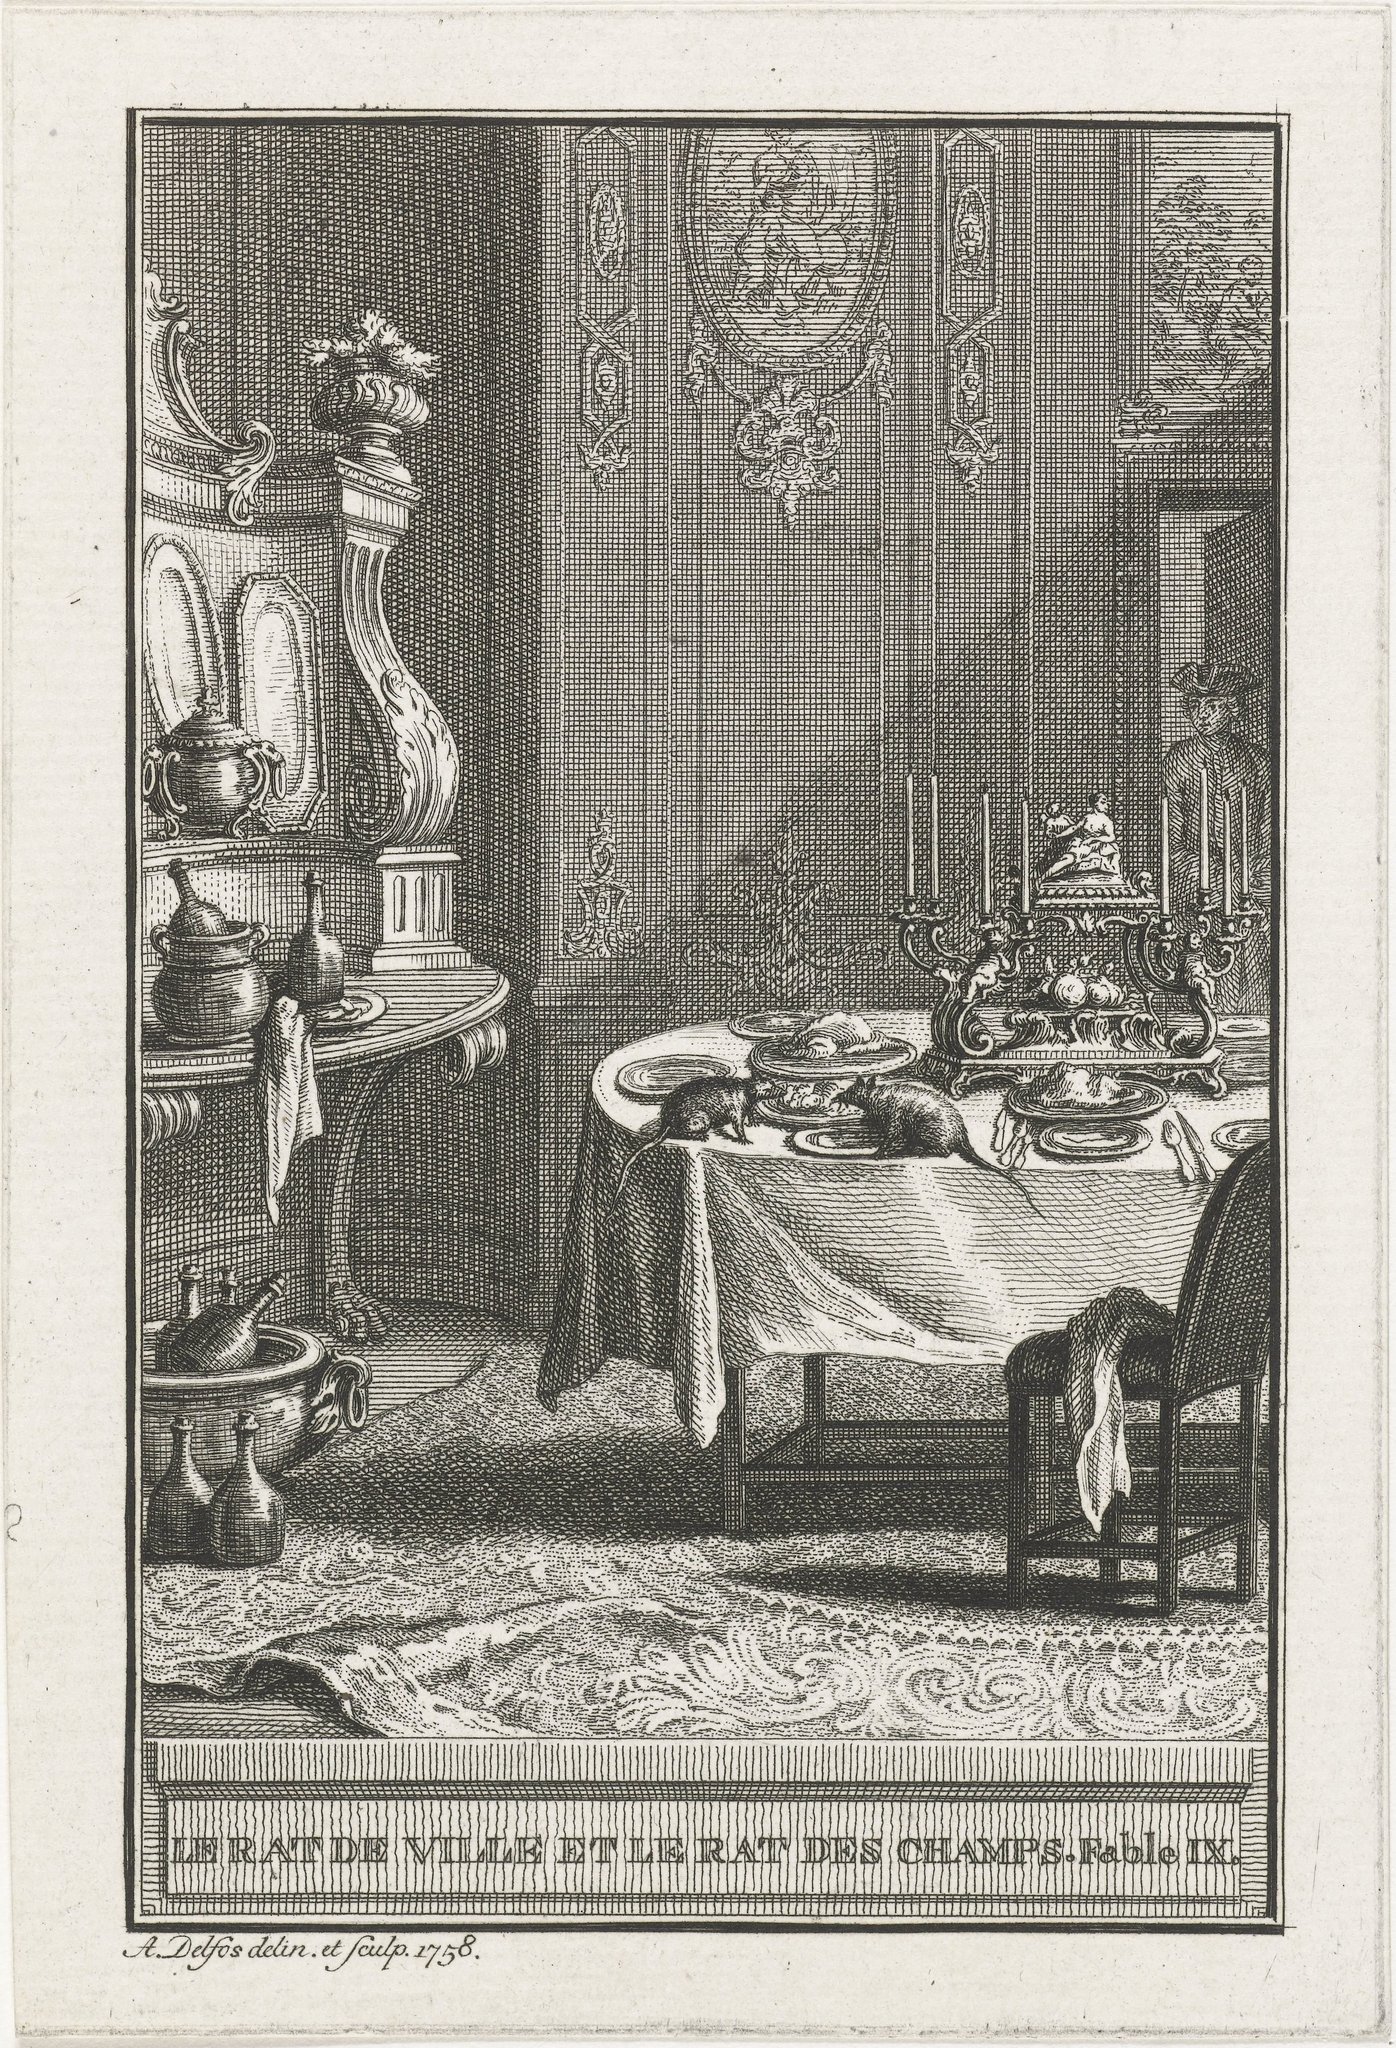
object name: print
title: Le rat de ville et le rat des champs. Fable IX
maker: abraham delfos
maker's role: draughtsman, painter, print maker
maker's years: 1731-1820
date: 1758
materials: paper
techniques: etching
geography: leiden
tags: rodents: rat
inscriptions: collector's mark: Lugt 240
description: Op een gedekte tafel eten twee ratten, de stadsrat en de veldrat, van de kliekjes van een maaltijd. Zij worden gestoord door iemand die het vertrek binnenkomt.